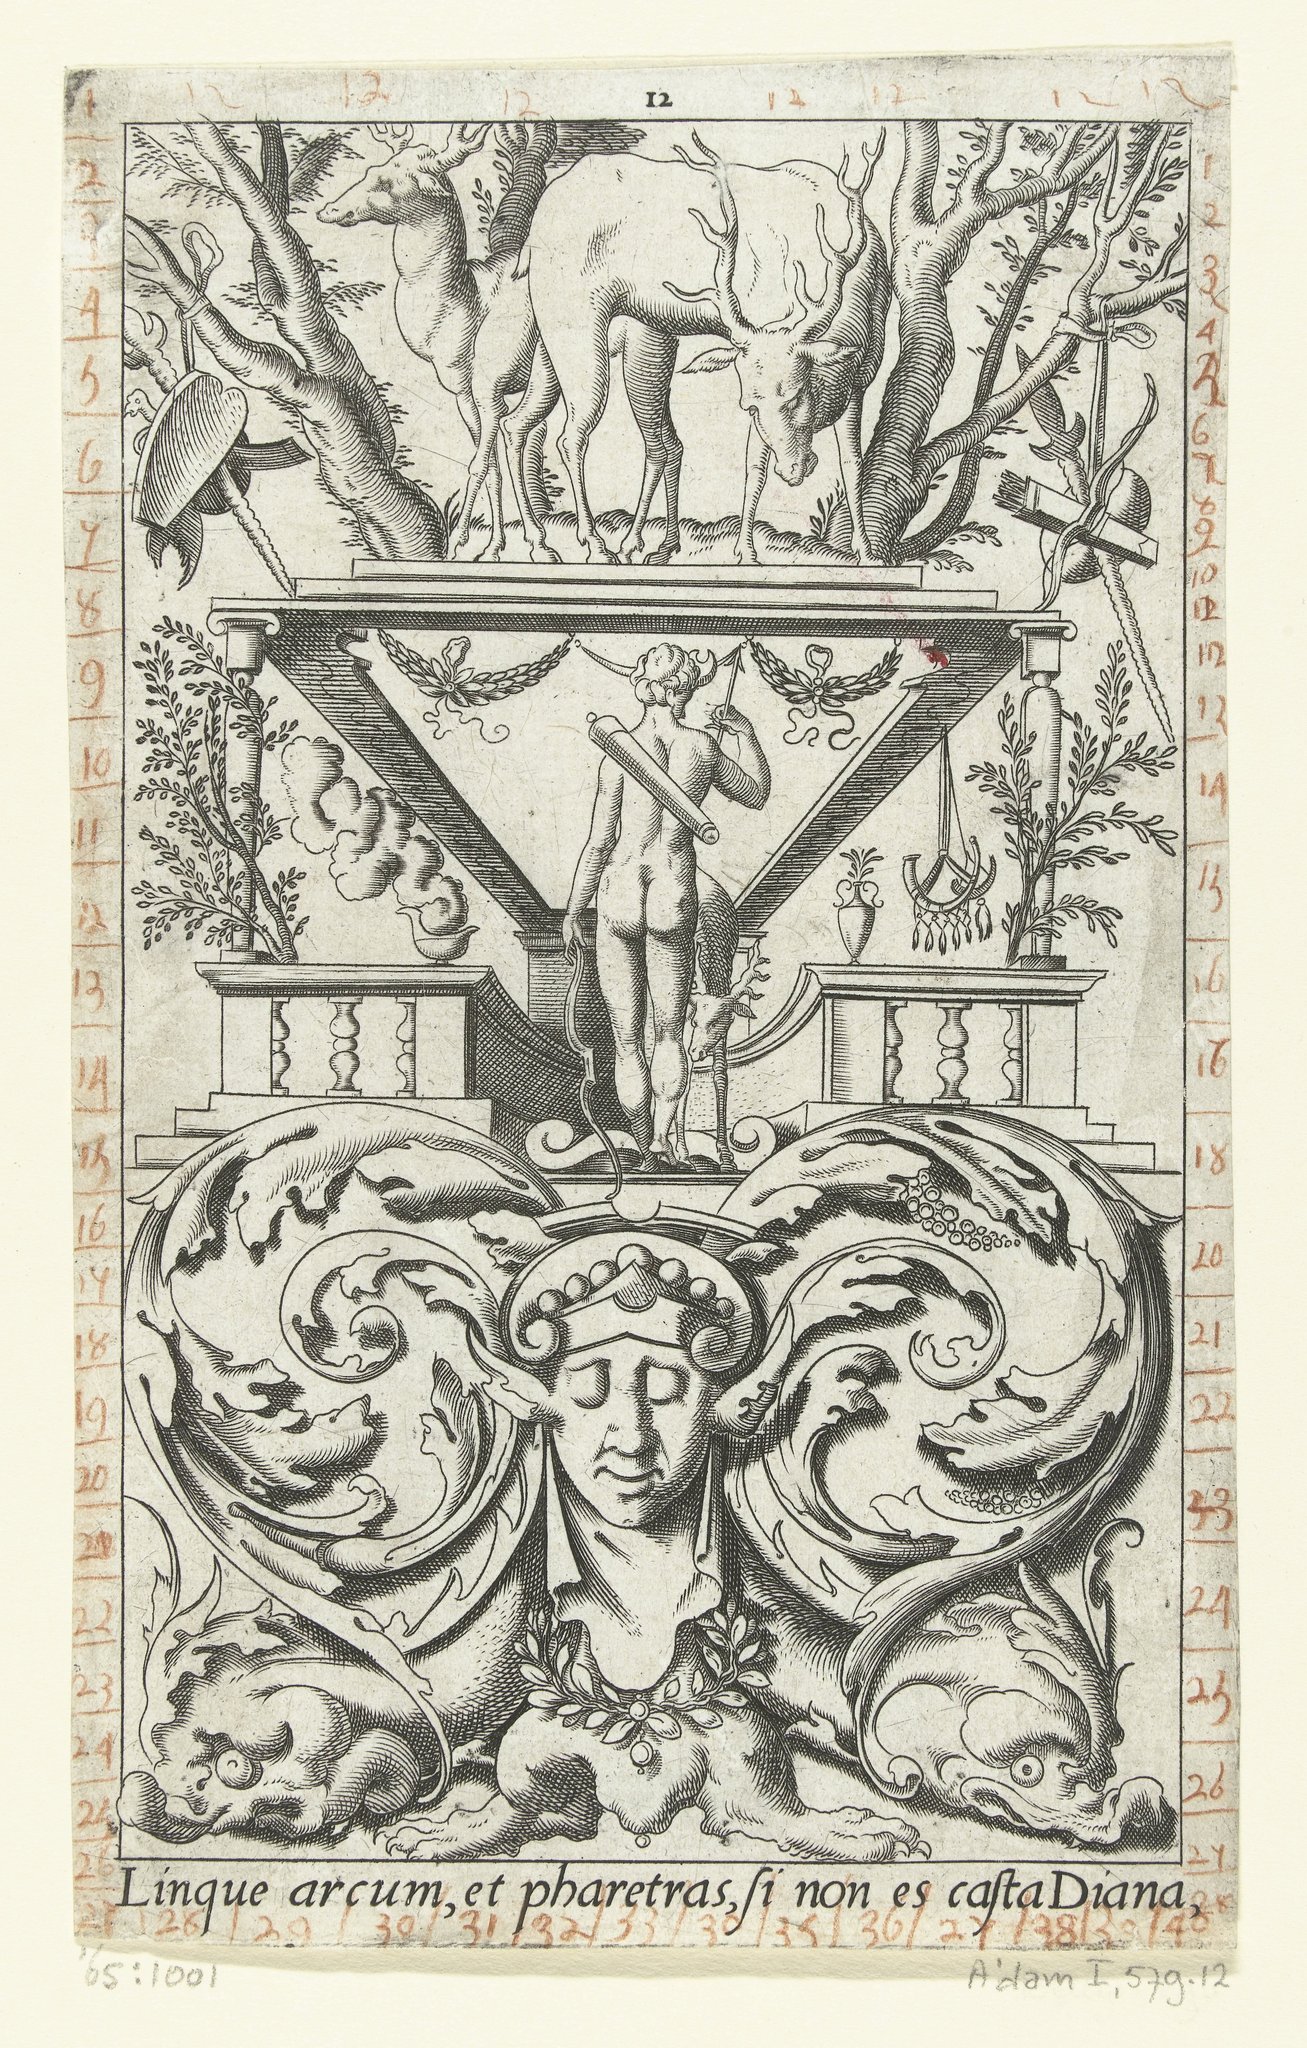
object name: ornament print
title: Diana, op de rug gezien, met boog en pijlenkoker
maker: rené boyvin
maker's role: print maker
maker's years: 1525-1598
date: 1551-1580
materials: paper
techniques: engraving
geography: france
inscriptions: inscription: ‘rondom de prent staan cijfers’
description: Onderaan staat een Latijnse tekst. Uit serie van 16 deels genummerde bladen met vlakdecoraties van goden en godinnen in een omlijsting van grotesken met fantastische wezens, dieren, guirlandes en mascarons.